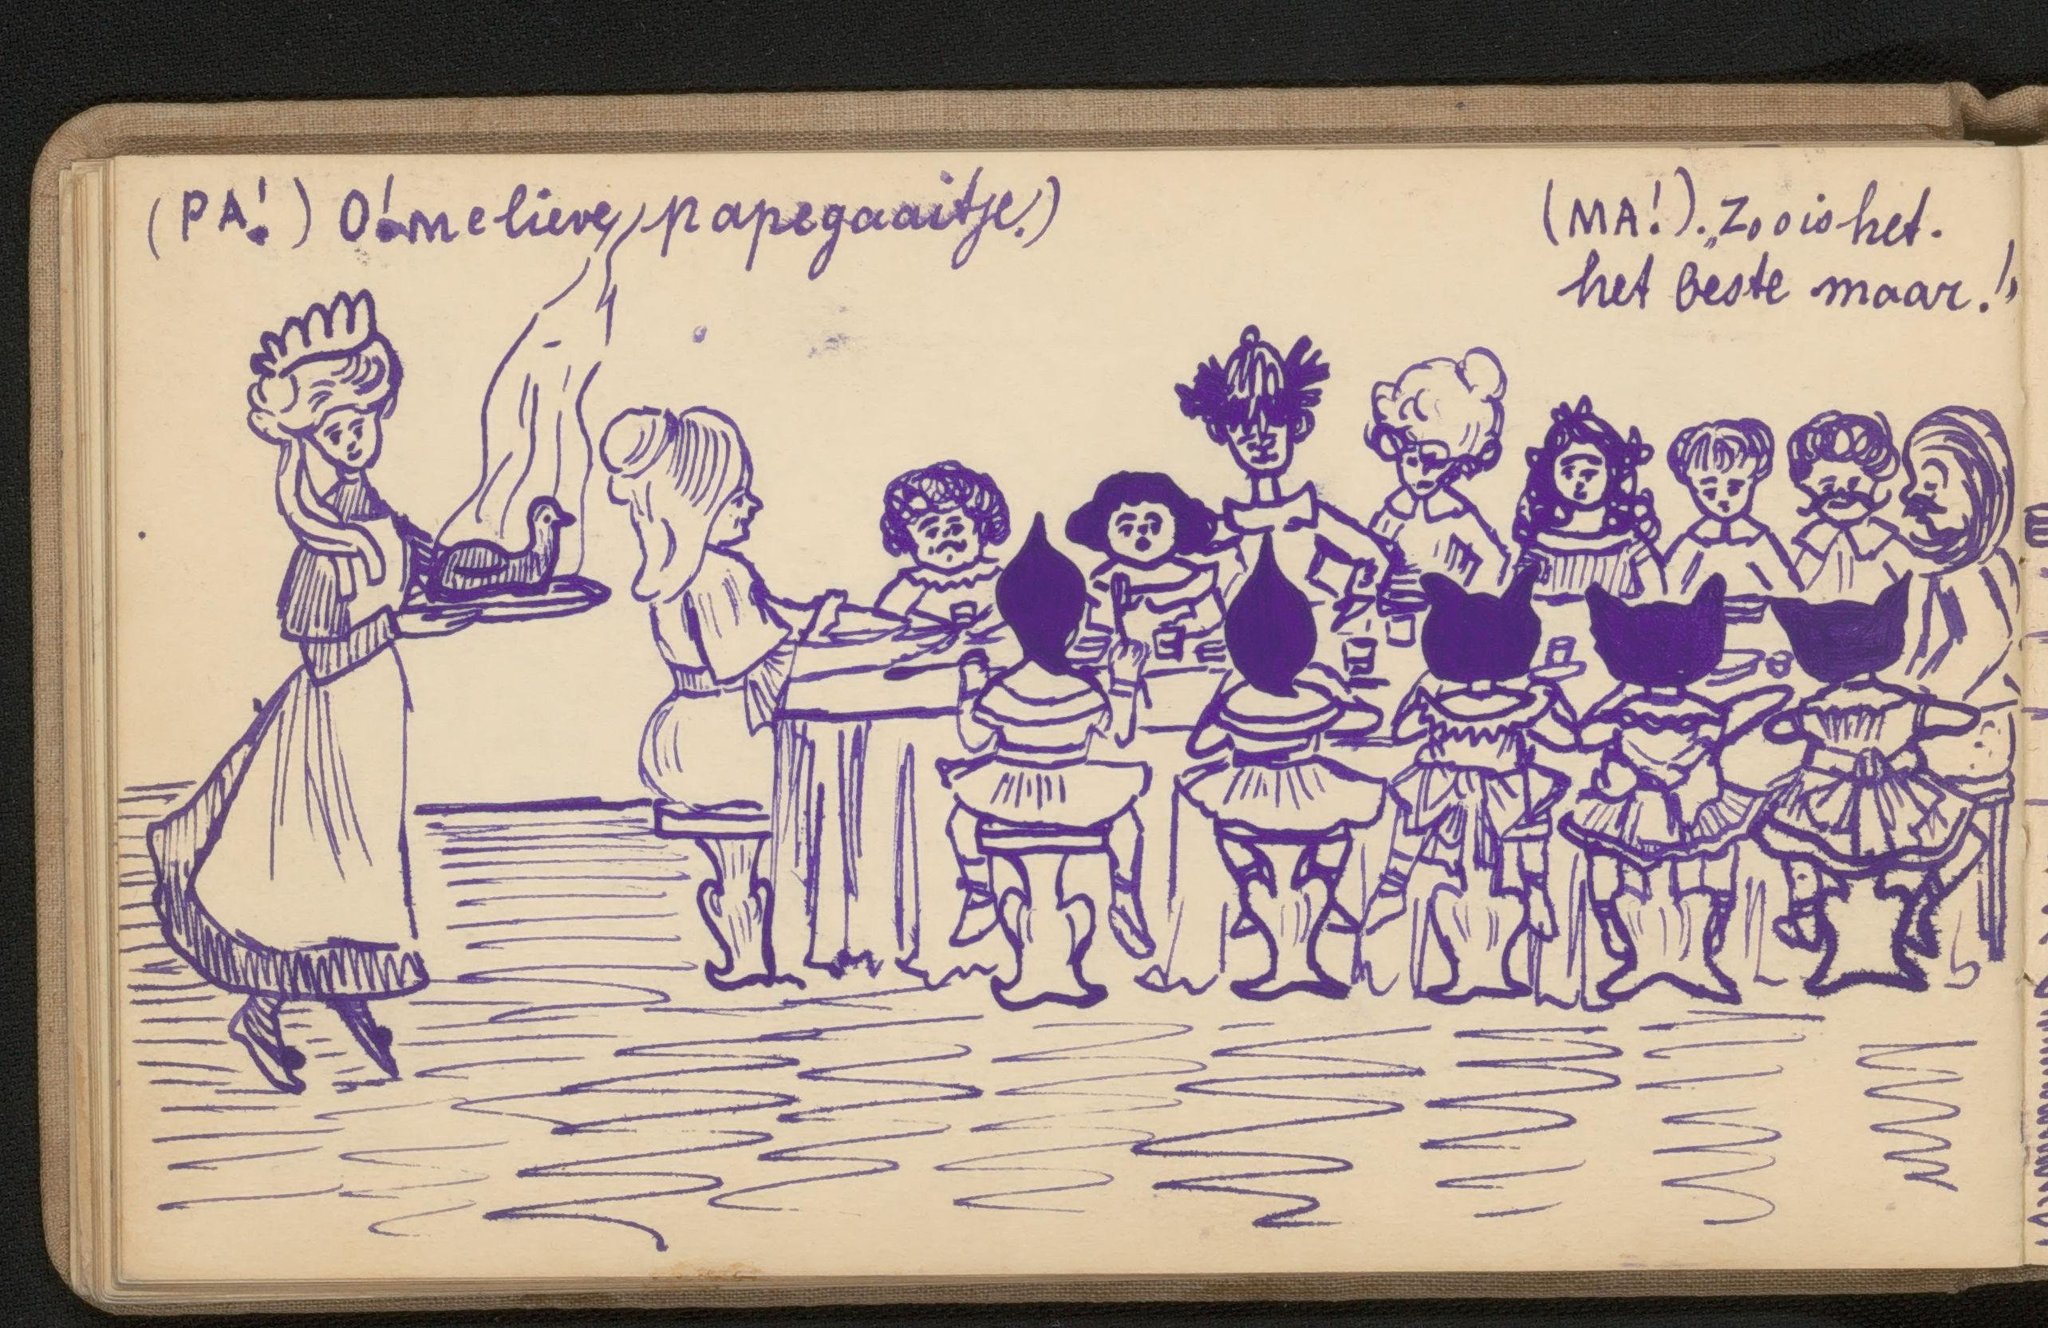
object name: sketchbook leaf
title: De papegaai wordt opgegeten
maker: Anonymous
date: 1875-1920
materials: ink, paper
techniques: pen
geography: netherlands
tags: ornamental birds: parrot, family life at home, dining-room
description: De papegaai wordt gebraden en geserveerd bij de maaltijd. Onderdeel van het schetsboek met humoristische tekeningen over het leven van een 'famille nombreuse'. Onderwerpsrubrieken binnen de Atlas Zeden en Gewoonten: Zeden en Gewoonten in Engeren Zin, Des menschen beging, midden en einde, Kinderleven.